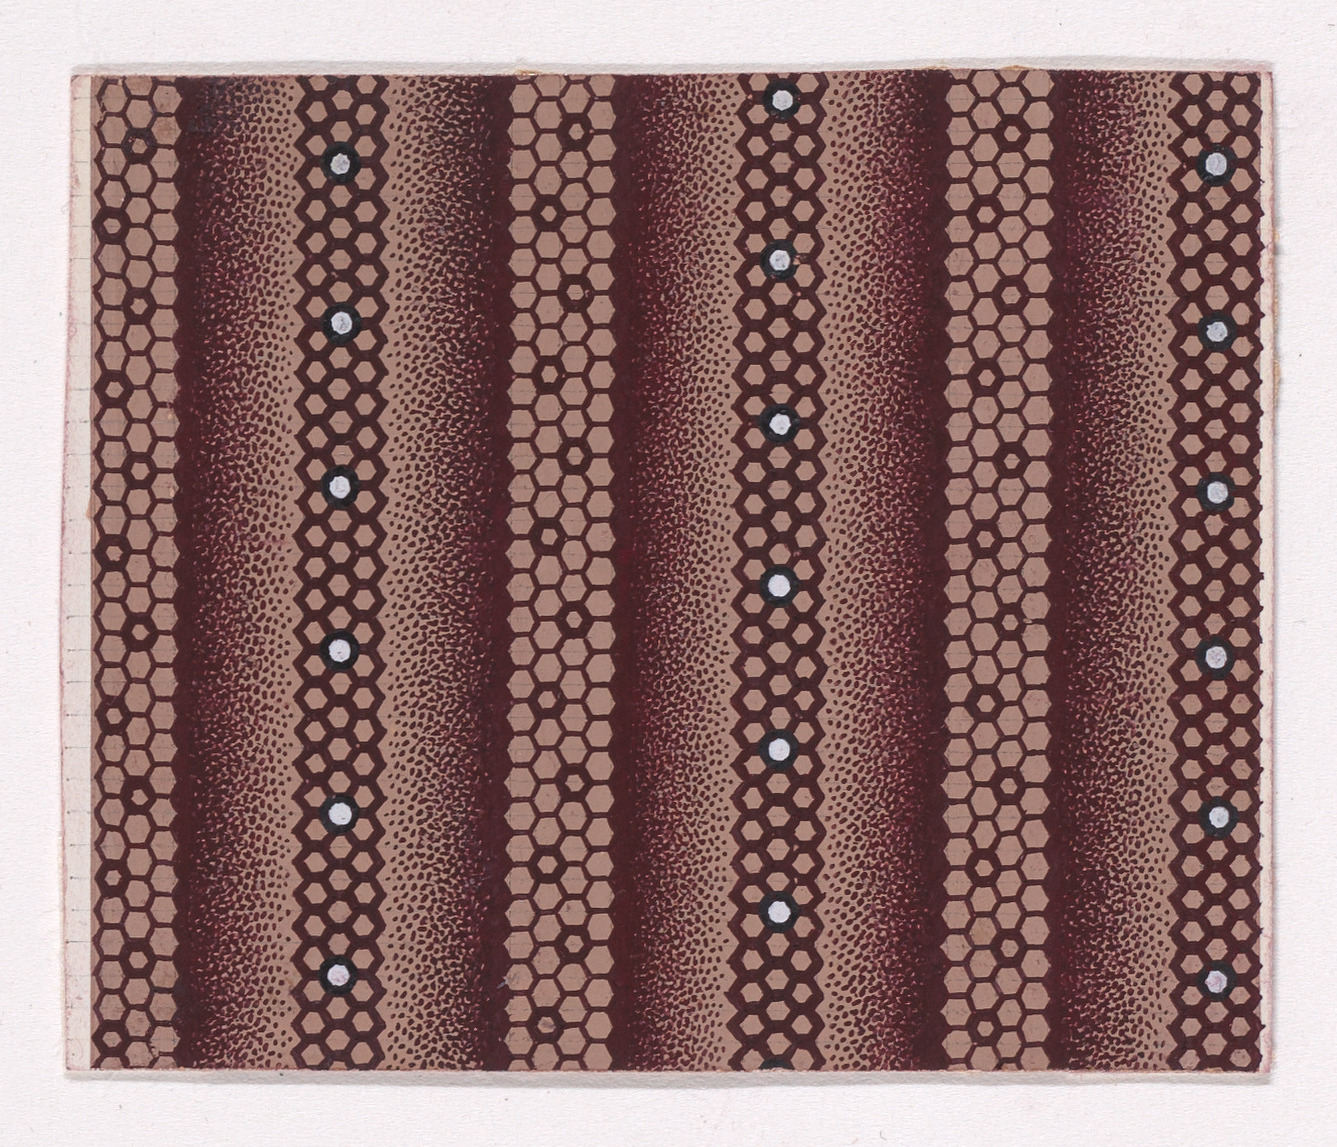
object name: drawing ornament architecture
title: Textile Design with Alternating Vertical Stripes of Honeycomb Patterns Decorated with Pearls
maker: anonymous, alsatian, 19th century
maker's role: artist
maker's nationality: alsatian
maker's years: 1800-1900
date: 1840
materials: gouache